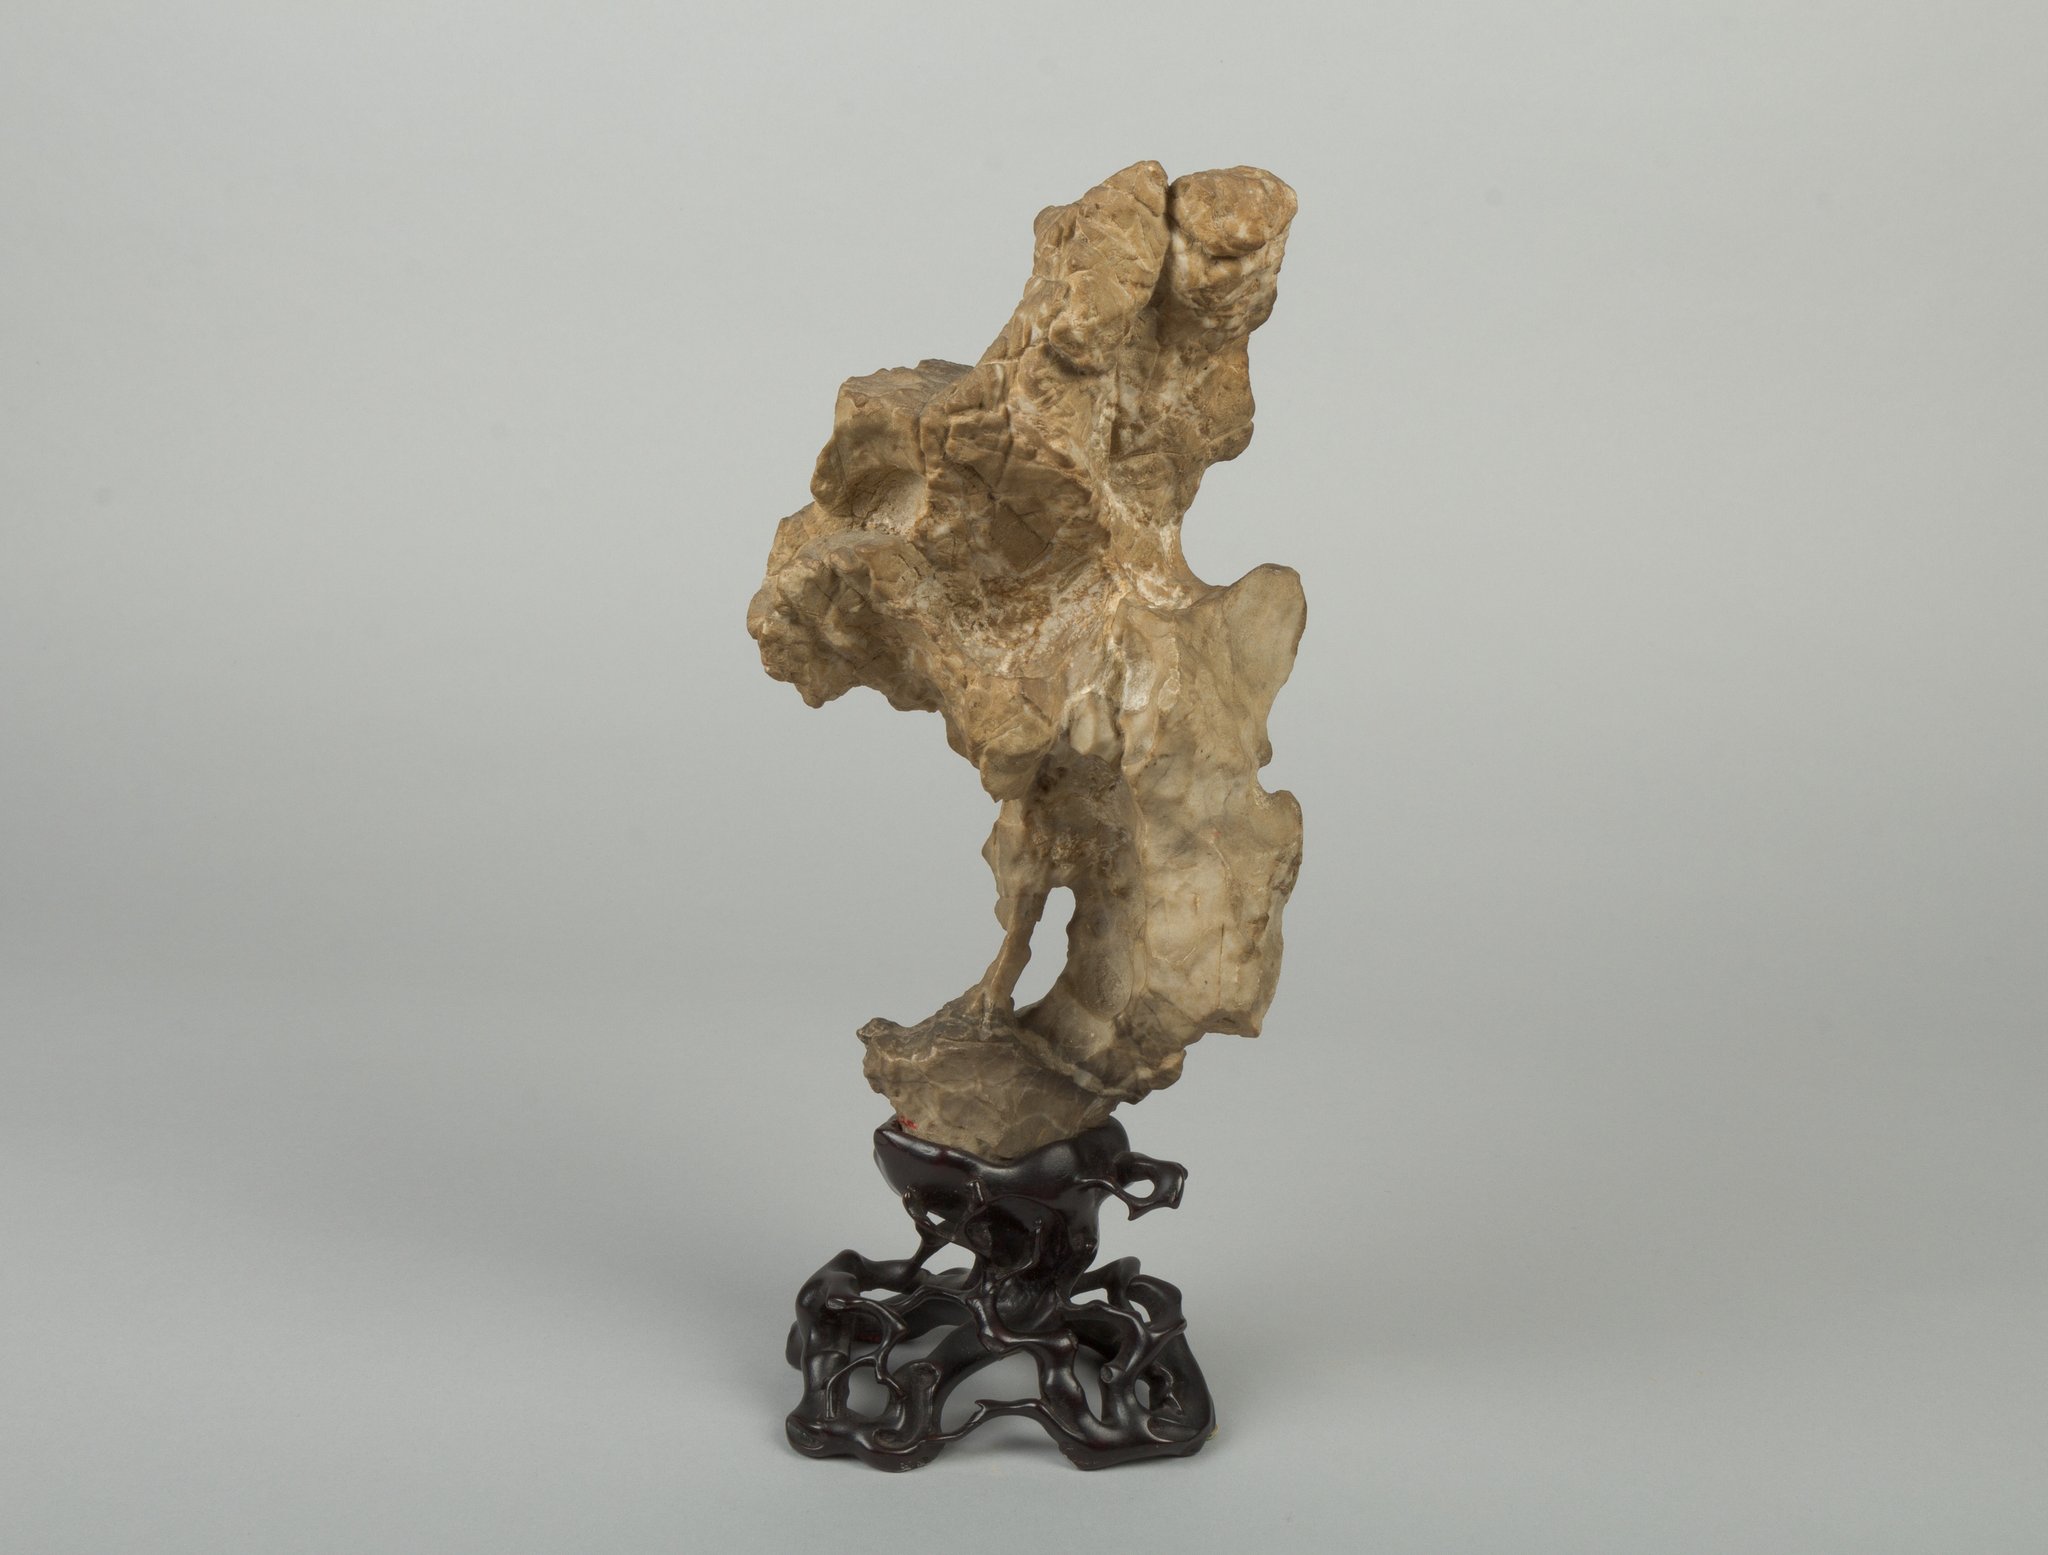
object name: scholar's rock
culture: chinese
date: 1701-1900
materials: limestone, wood